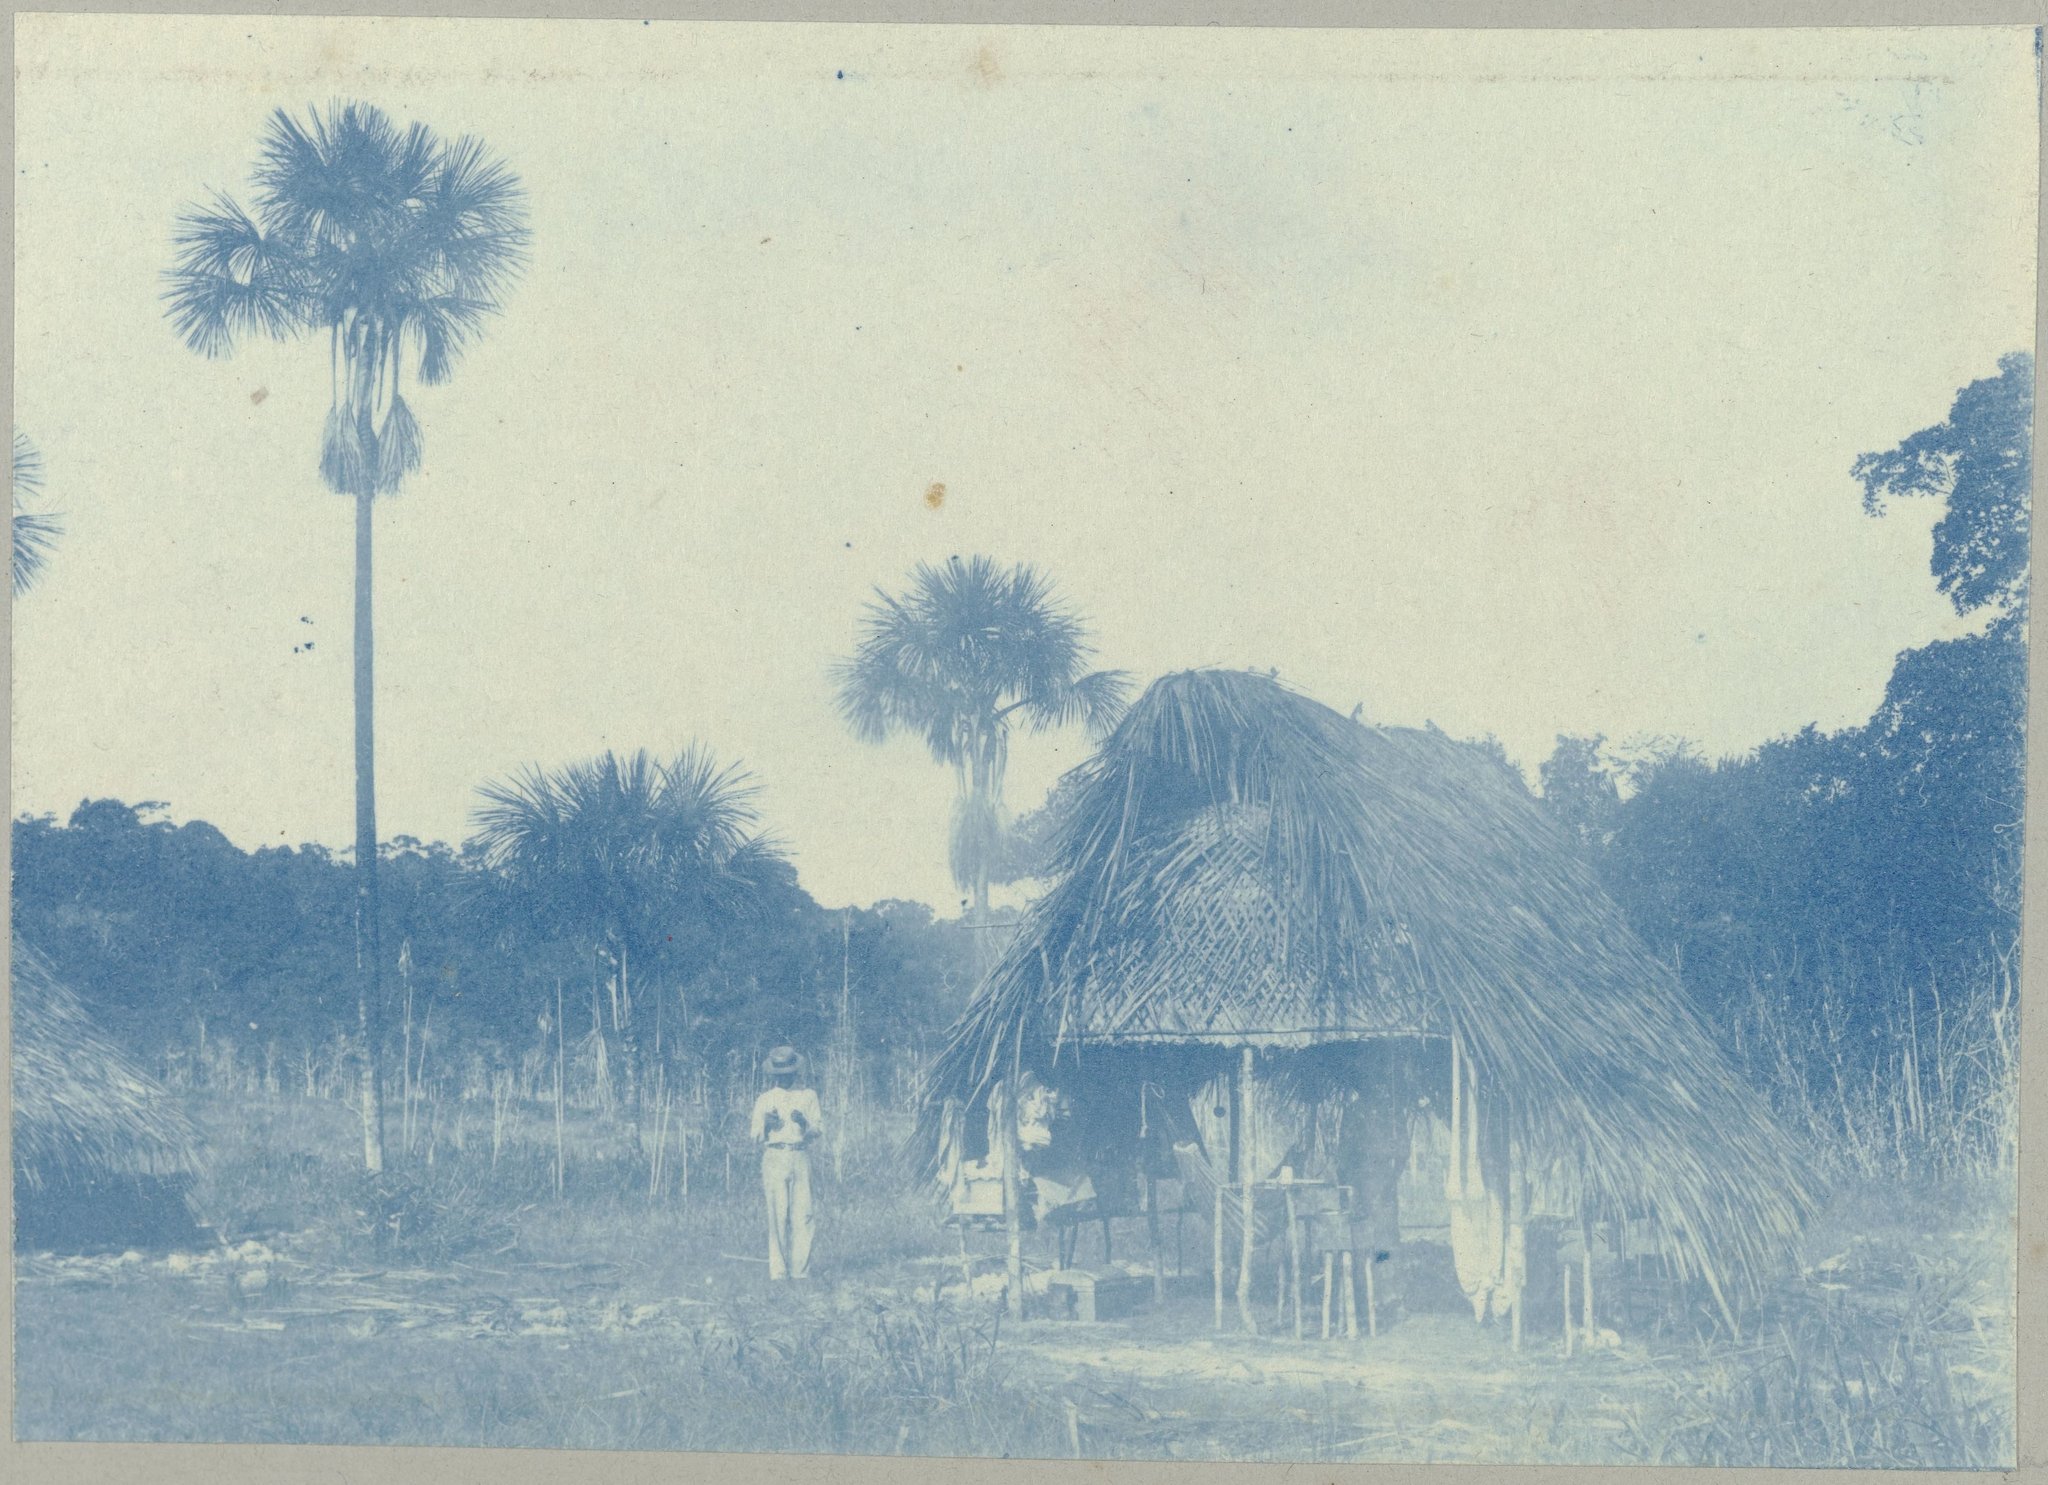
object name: photograph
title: Kampen op Patrick-savanna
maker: hendrik doijer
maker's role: engineer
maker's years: 1863-1925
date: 1903-1910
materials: photographic support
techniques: cyanotype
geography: suriname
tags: suriname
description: Een woning in een kamp op de Patrick-savanna. Onderdeel van het fotoalbum Souvenir de Voyage (deel 3), over het leven van de familie Doijer in en rond de plantage Ma Retraite in Suriname in de jaren 1903-1910.